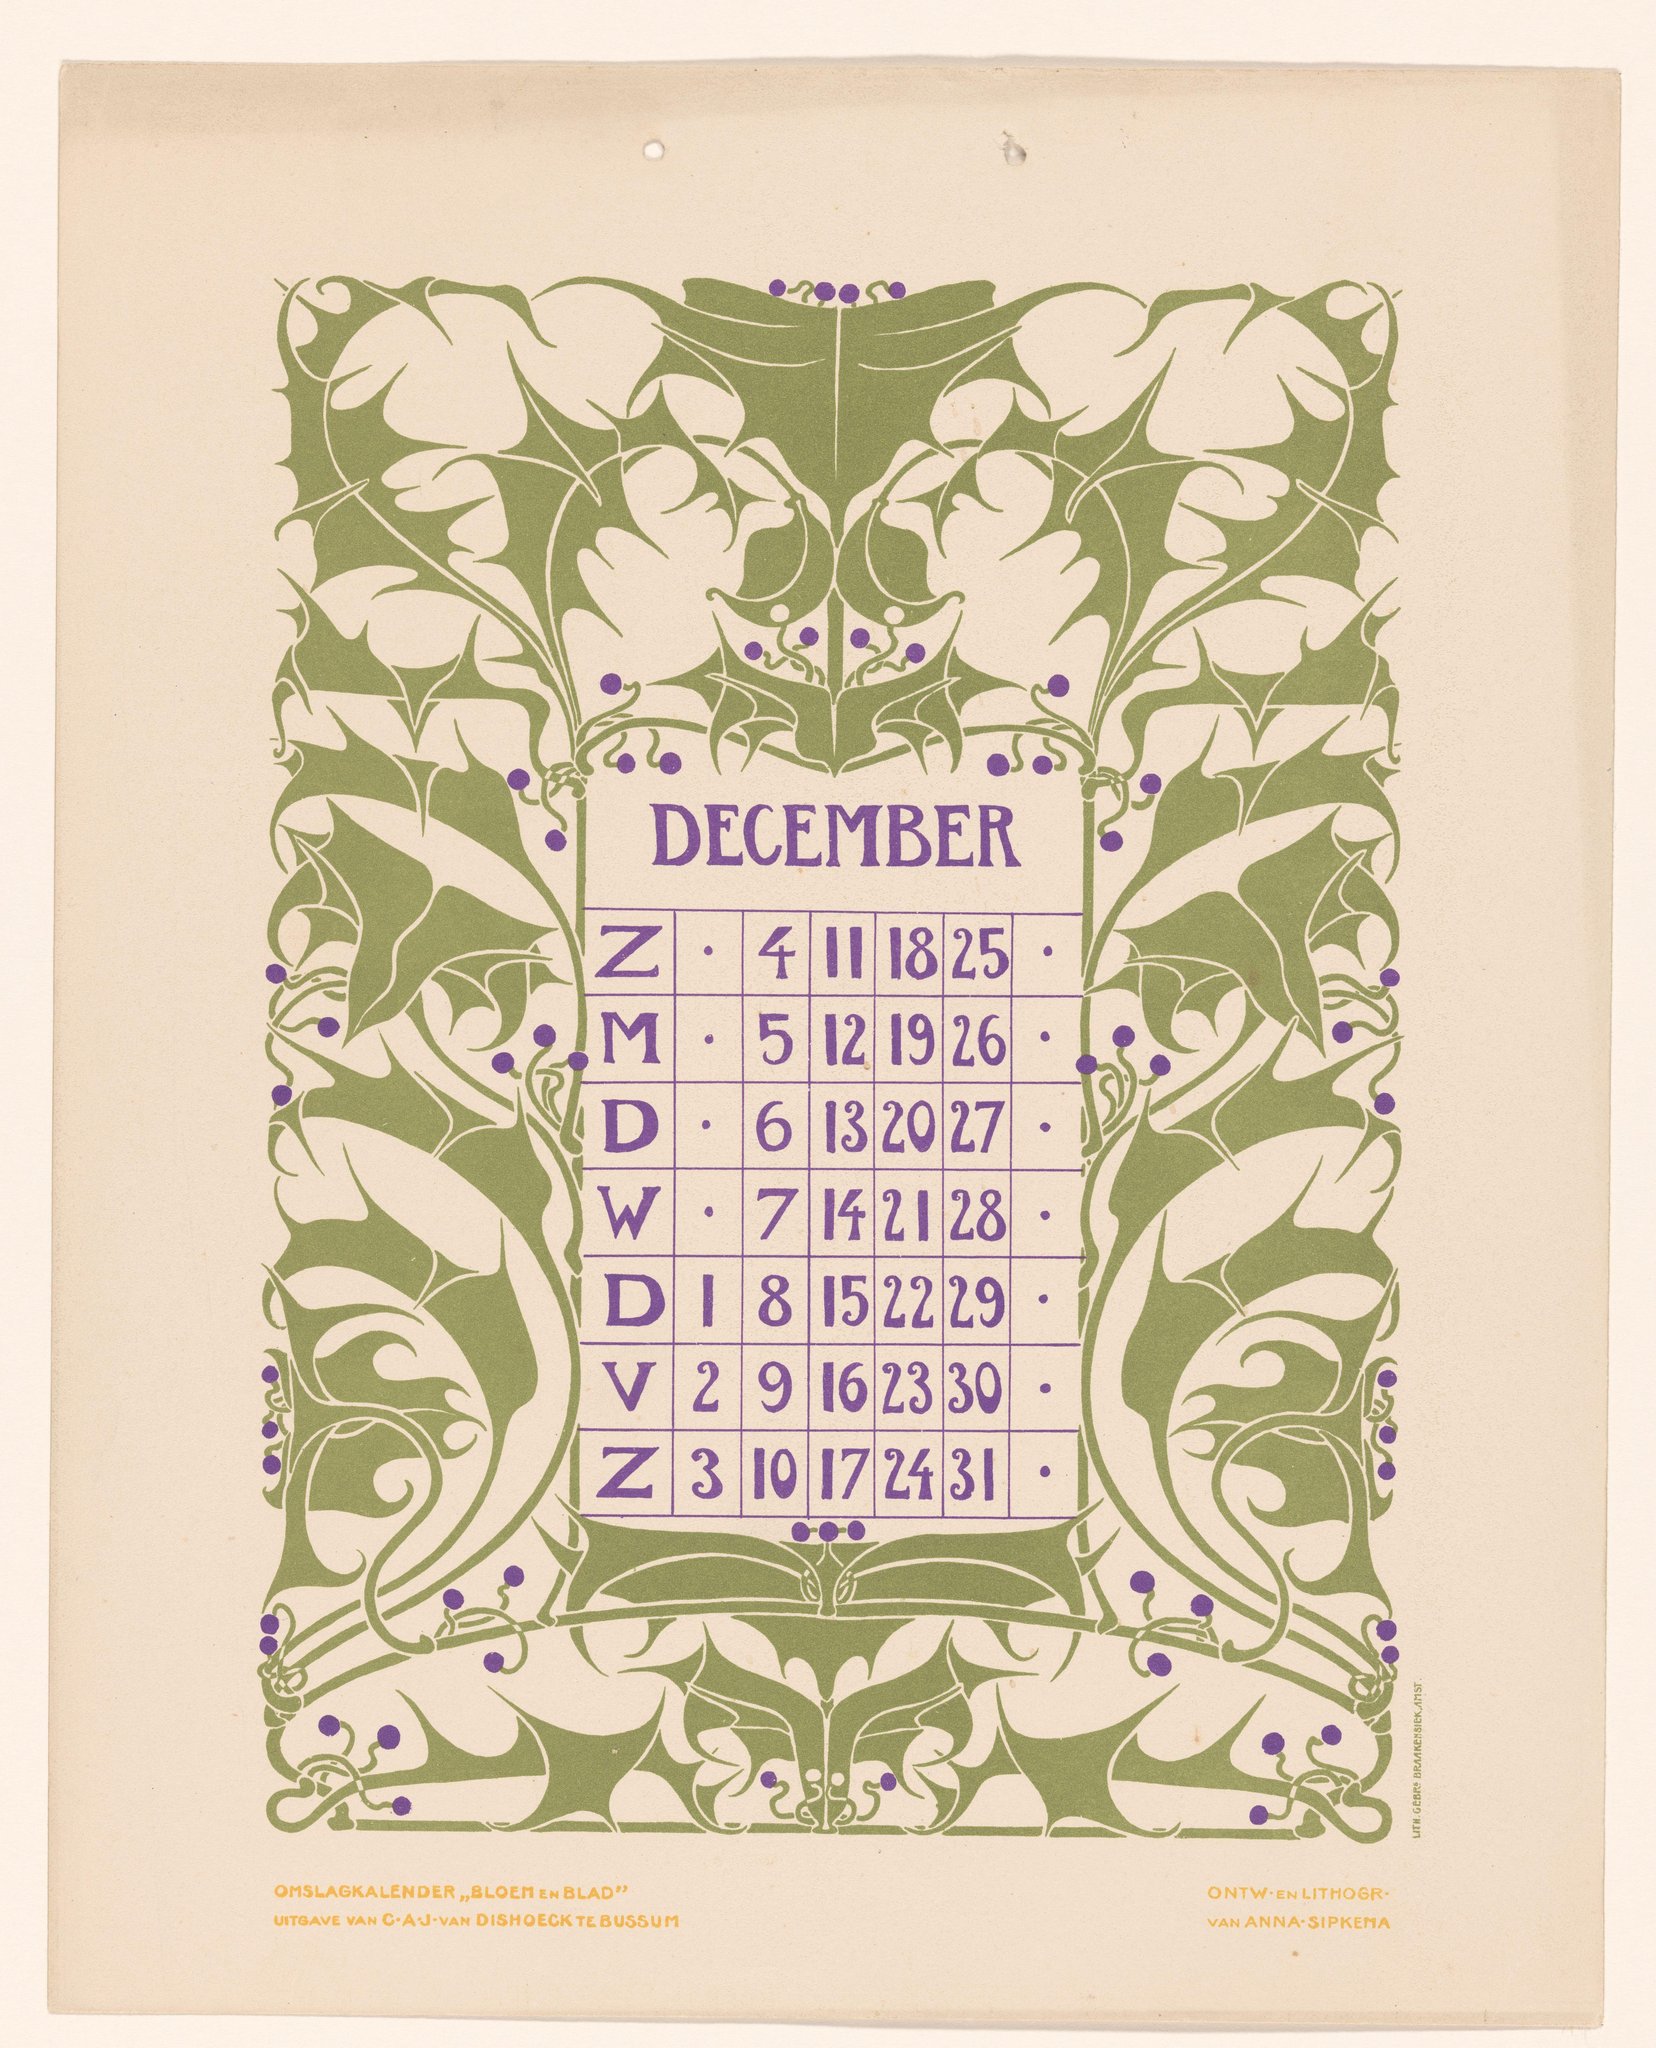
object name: print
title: Kalenderblad december met hulst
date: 1904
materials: paper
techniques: lithograph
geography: bussum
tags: shrubs: holly, december ~ other concepts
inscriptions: collector's mark: Lugt 2228